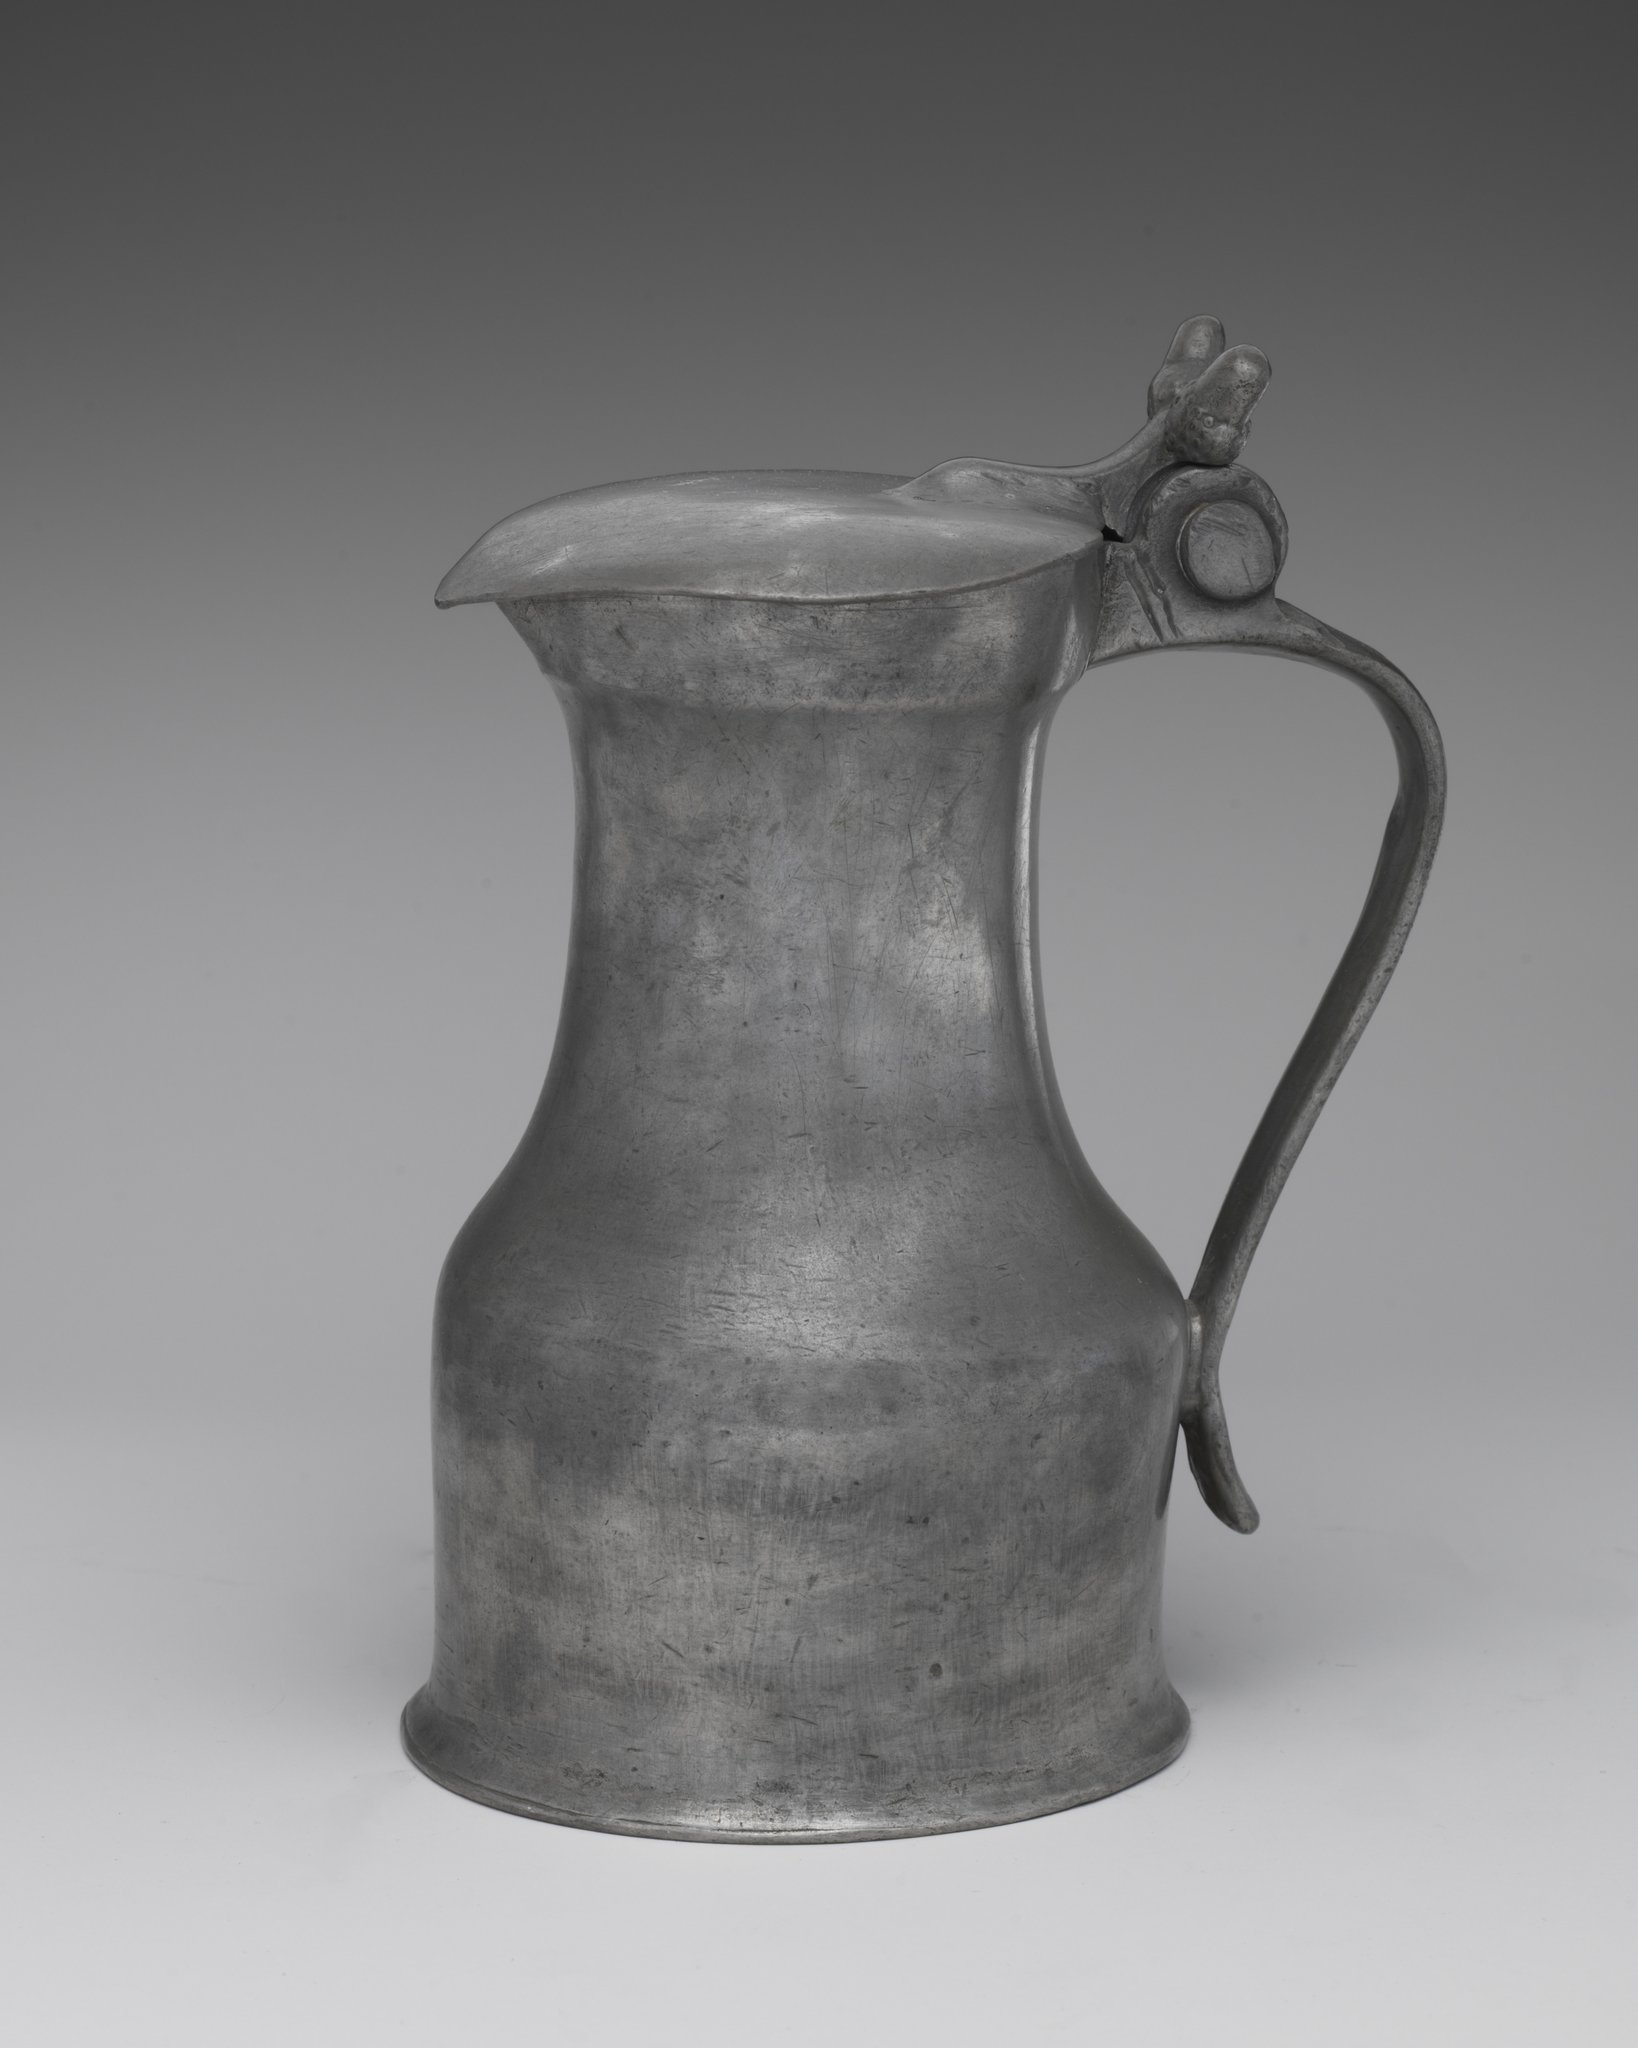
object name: measure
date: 1701-1800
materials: pewter